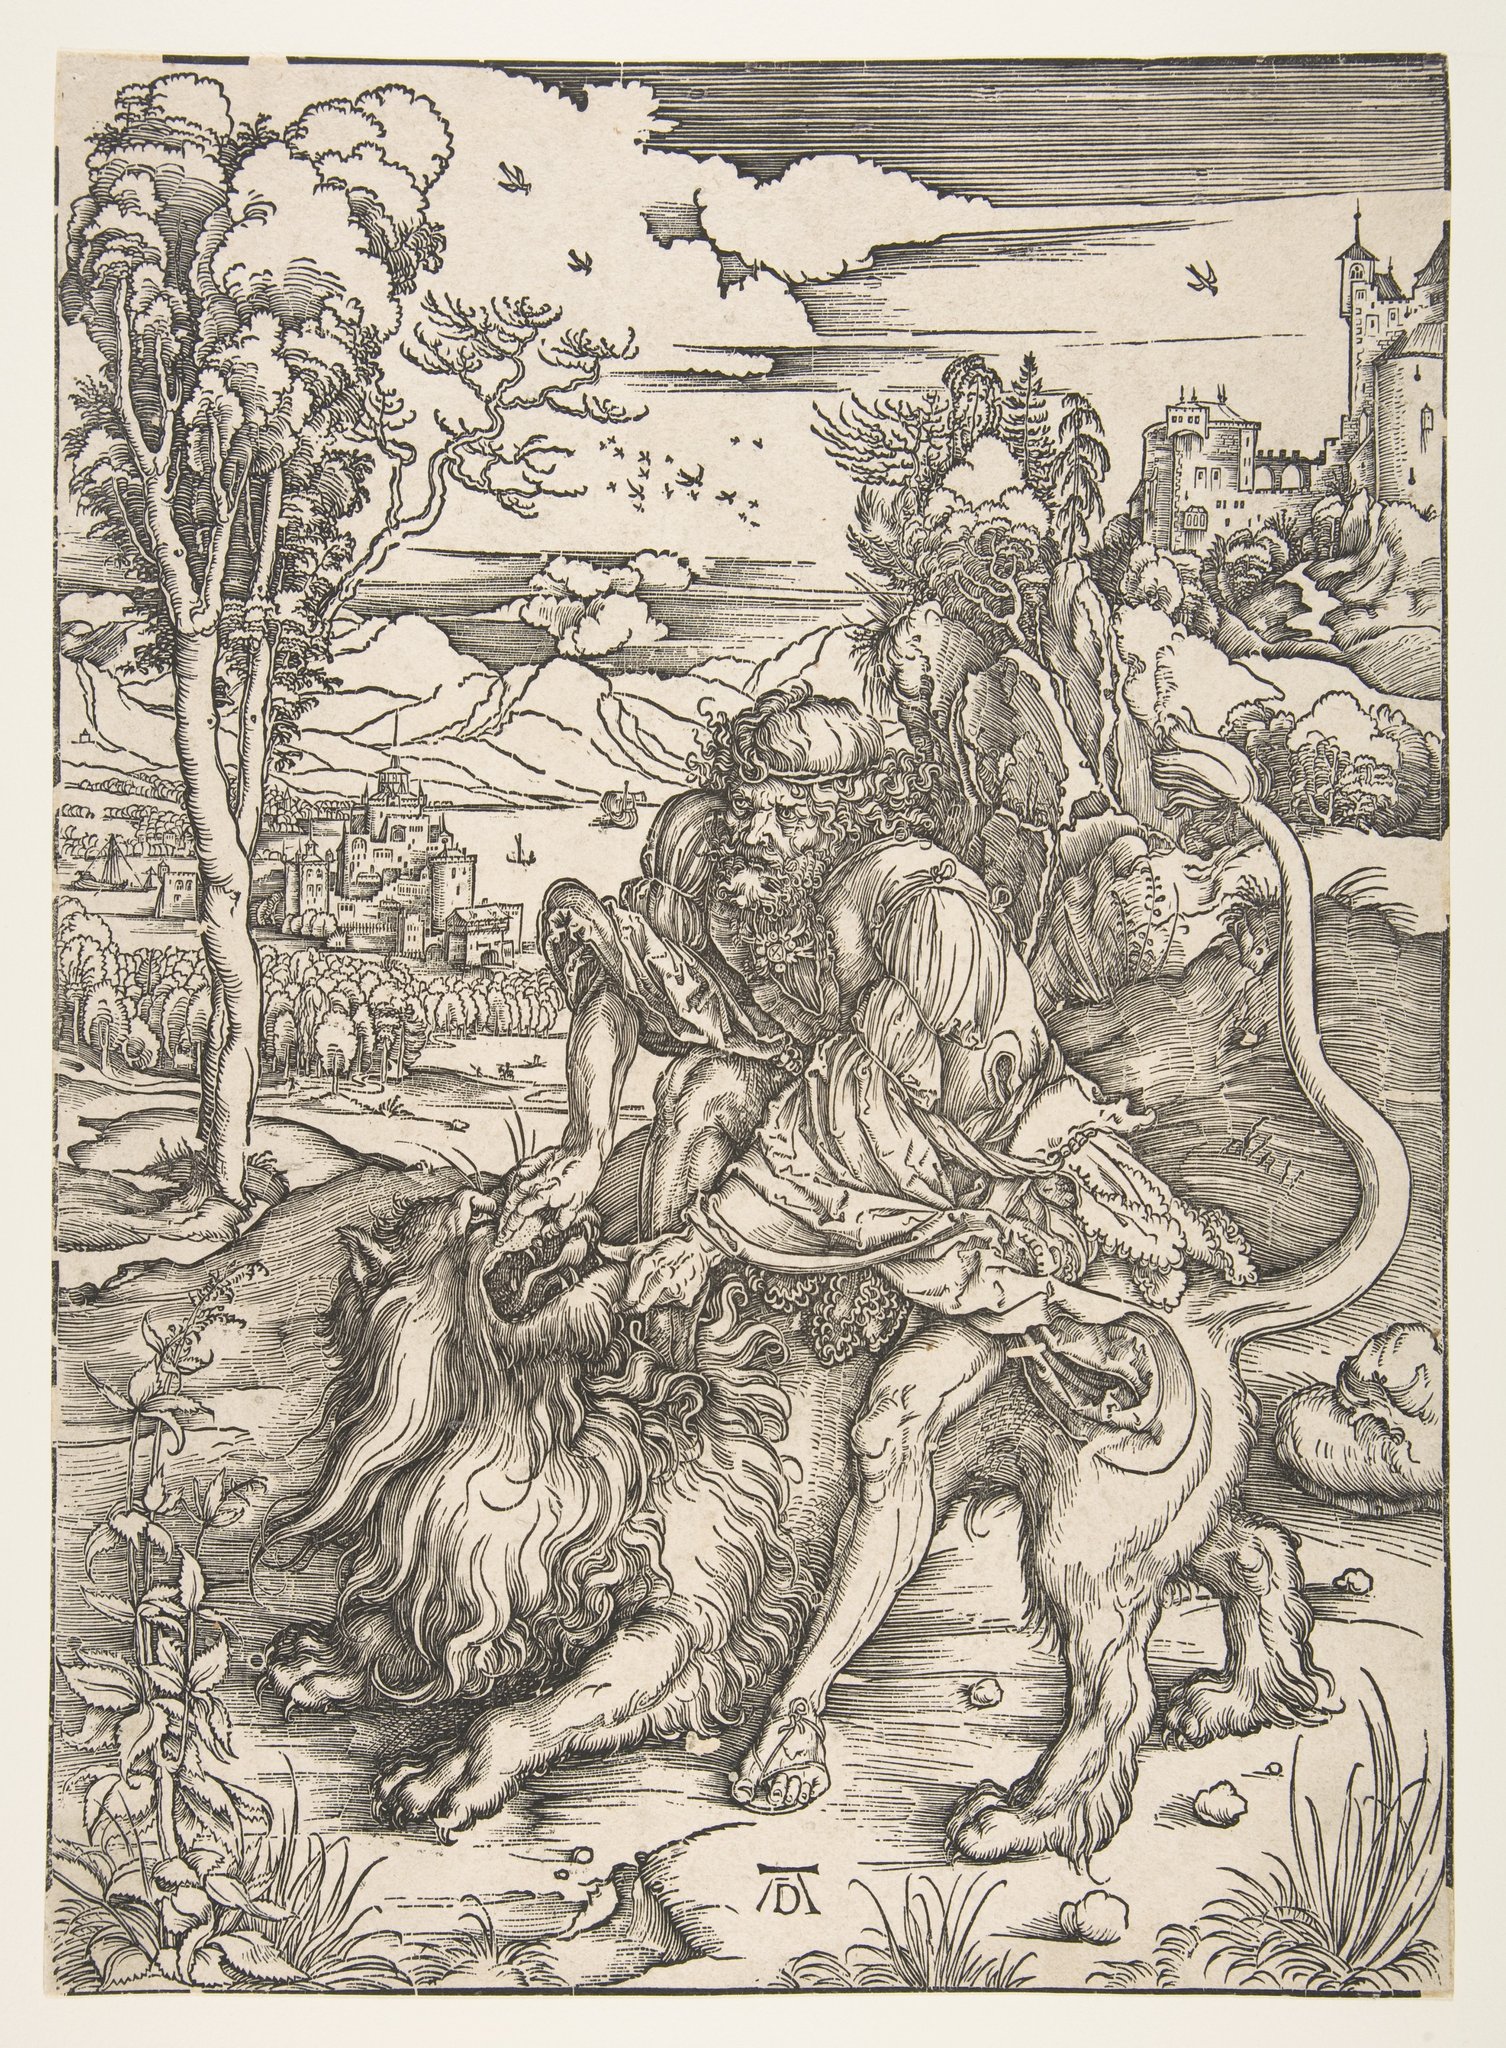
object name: print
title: Samson Rending the Lion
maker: albrecht dürer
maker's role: artist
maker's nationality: german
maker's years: 1471-1528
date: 1497-1498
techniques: woodcut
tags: lions,samson